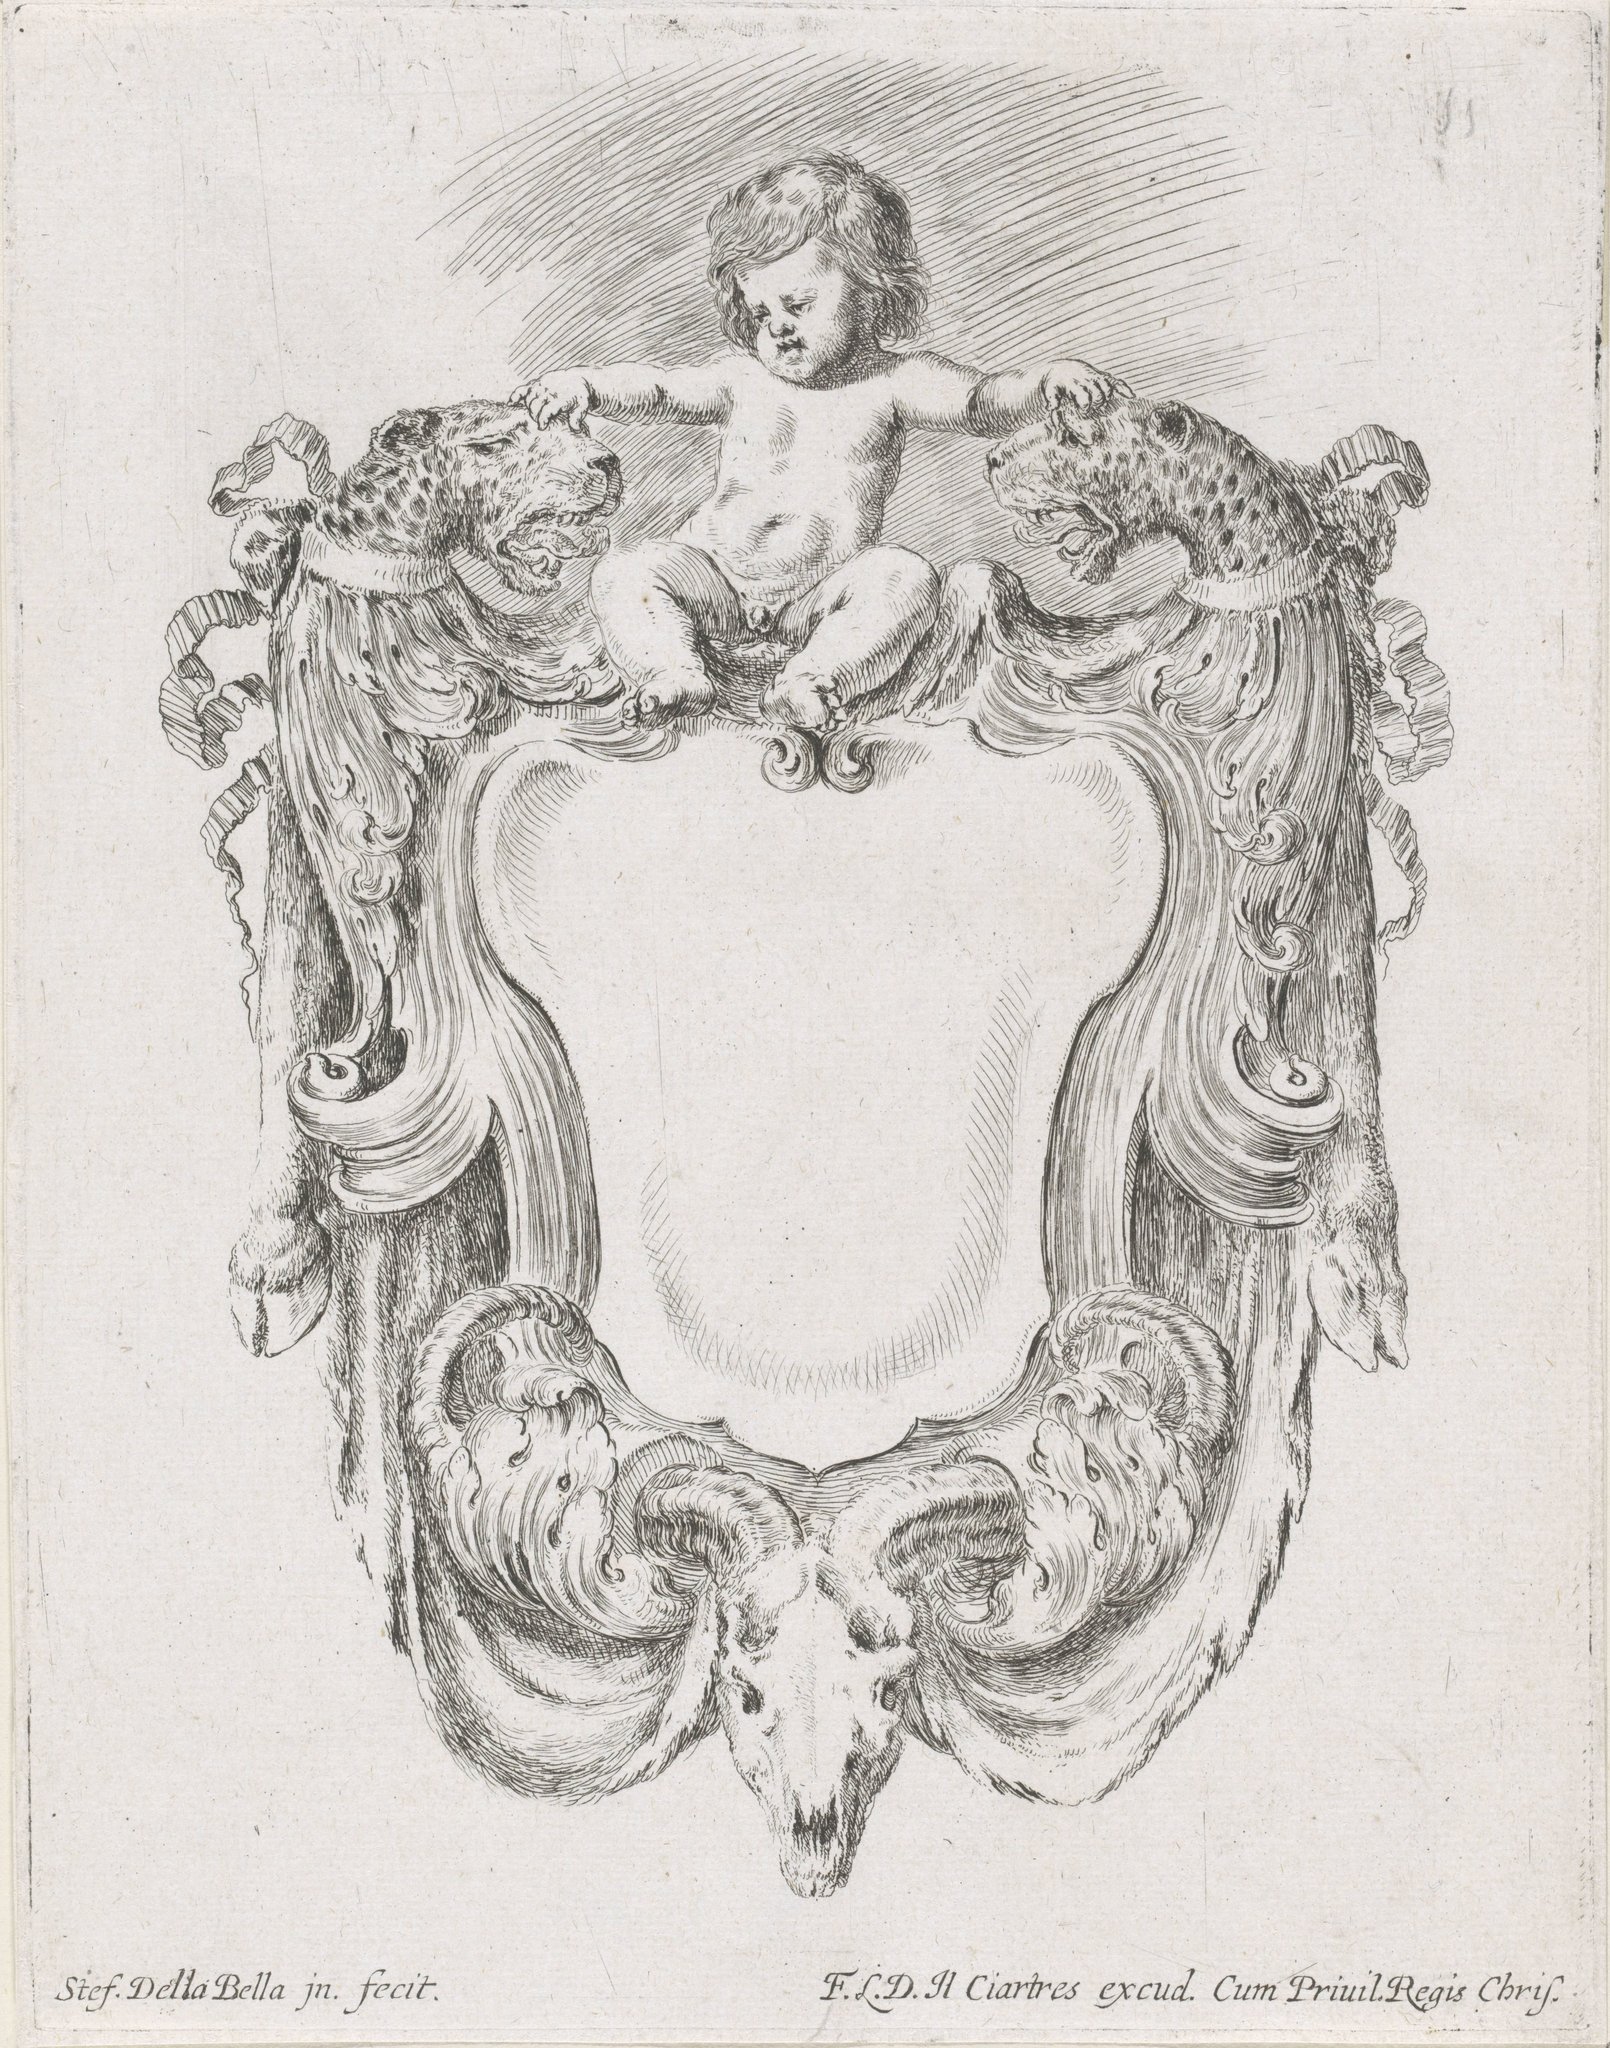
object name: ornament print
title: Cartouche met een putto, twee panterkoppen en een schedel van een ram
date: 1646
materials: paper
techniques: etching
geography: france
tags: ram's head ~ ornament, beasts of prey, predatory animals: panther, ornament ~ cartouche, cupids: 'amores', 'amoretti', 'putti'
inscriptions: collector's mark: Lugt 240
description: Prent uit een reeks van achttien prenten.